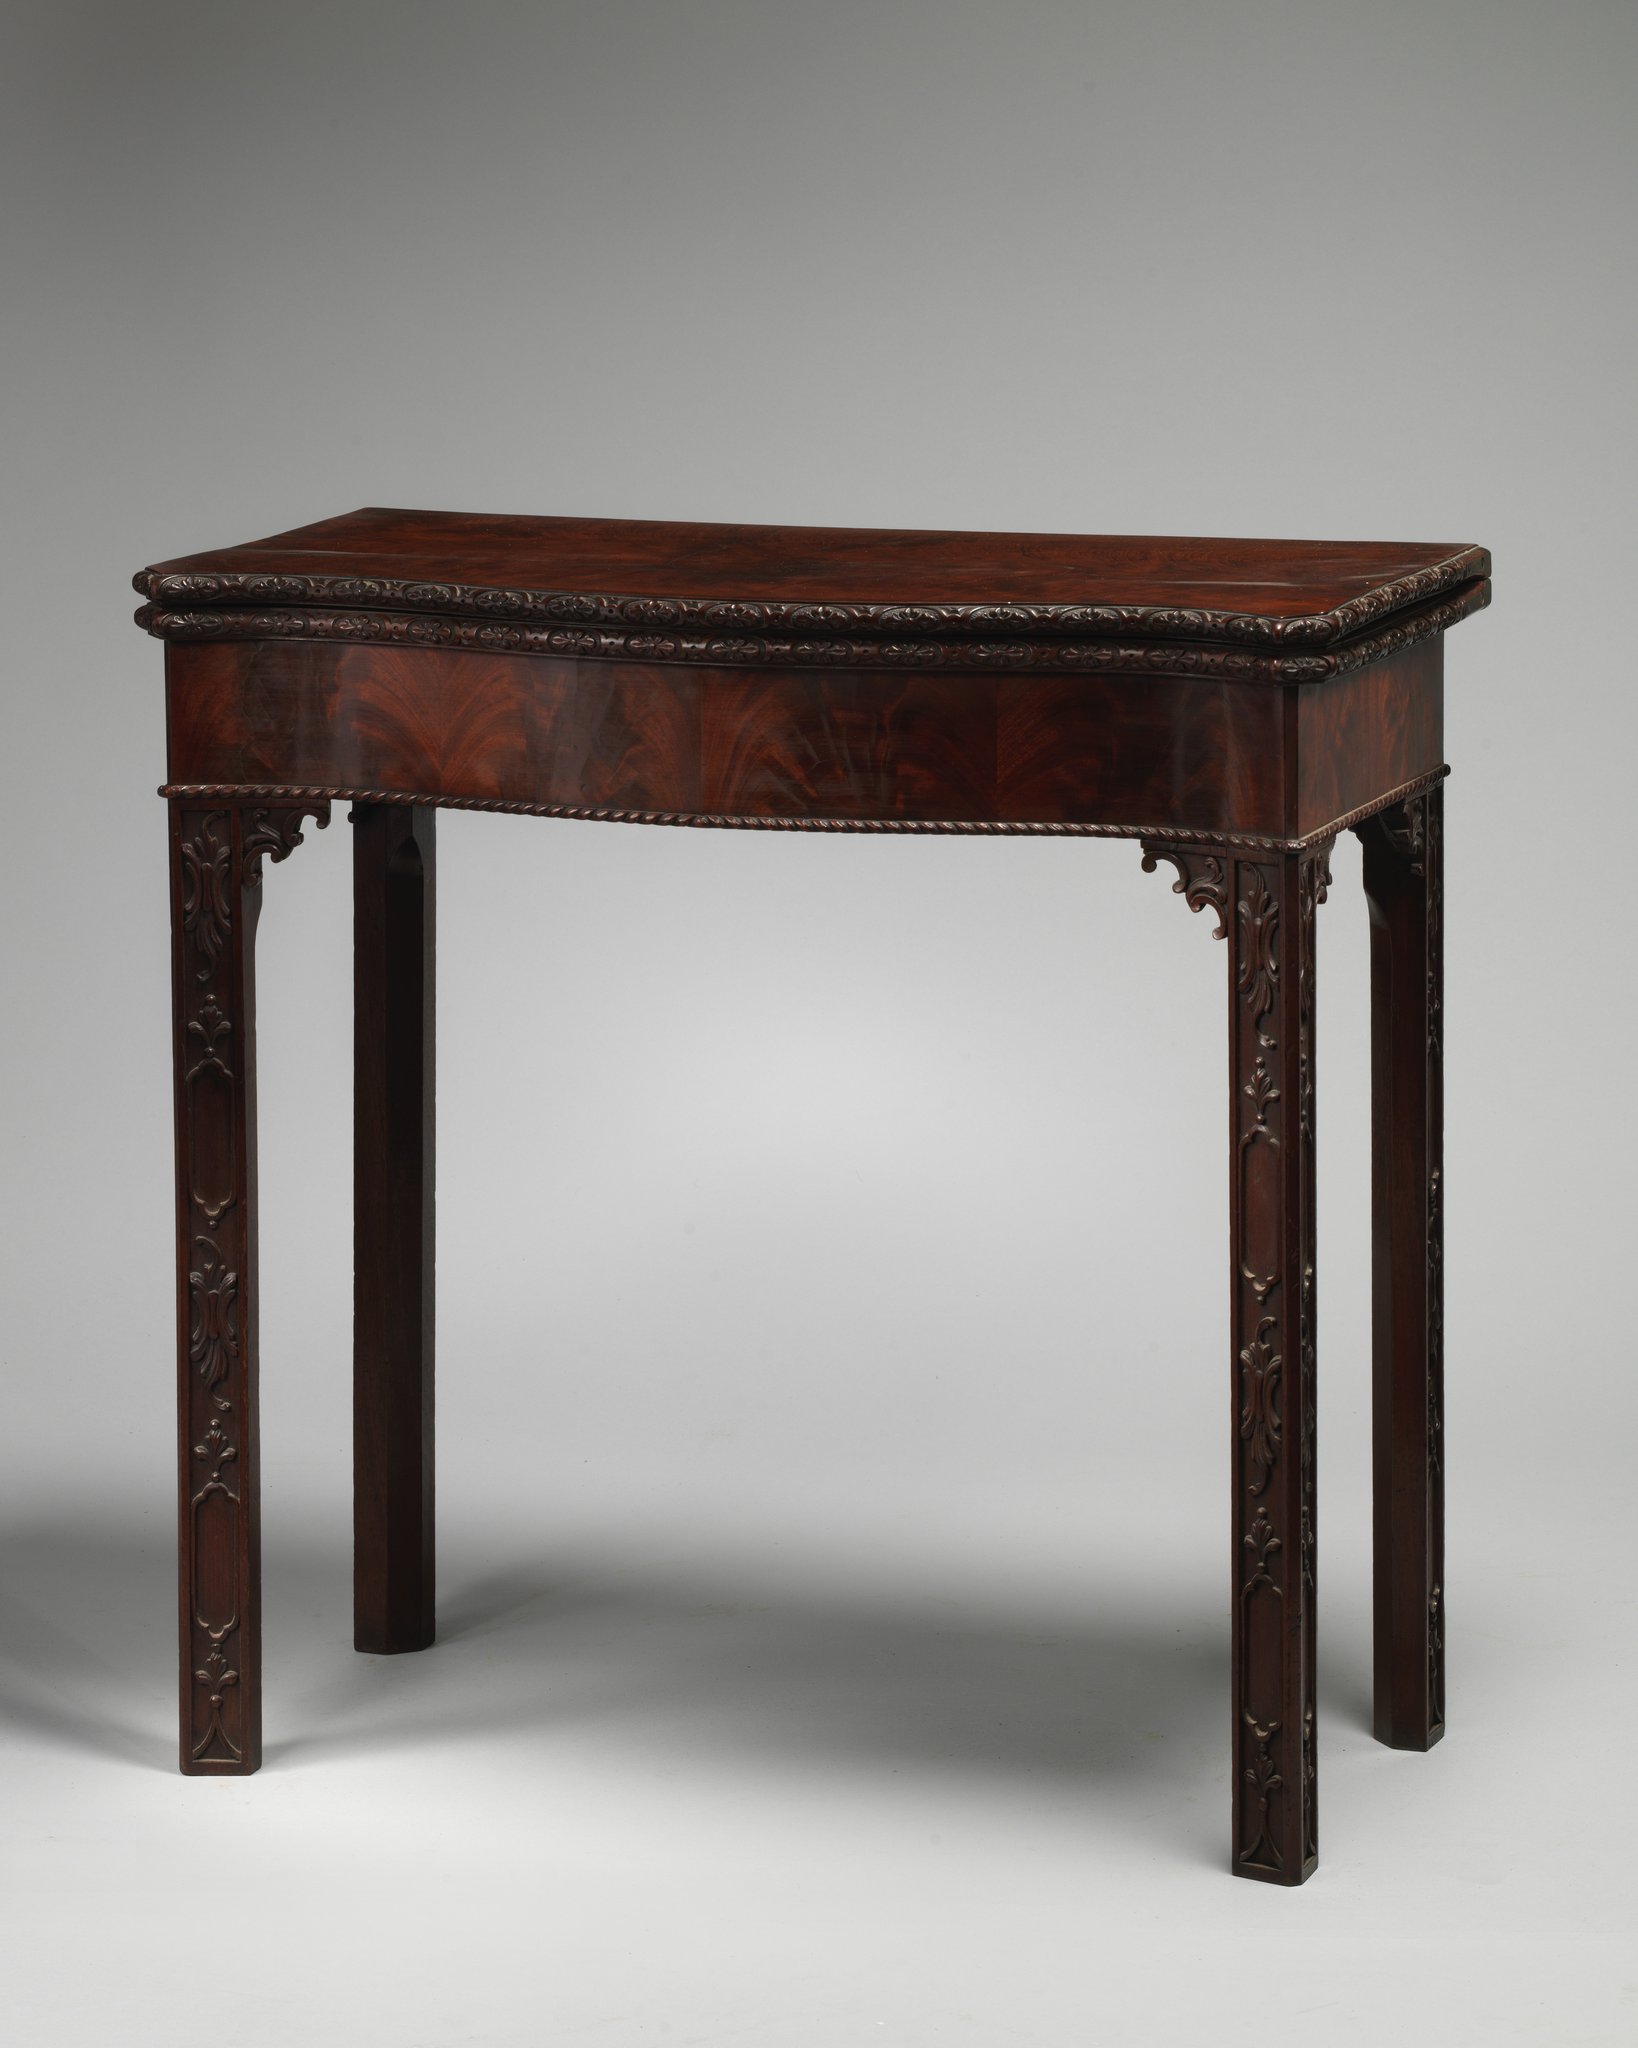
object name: card table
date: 1765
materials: wood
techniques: damask